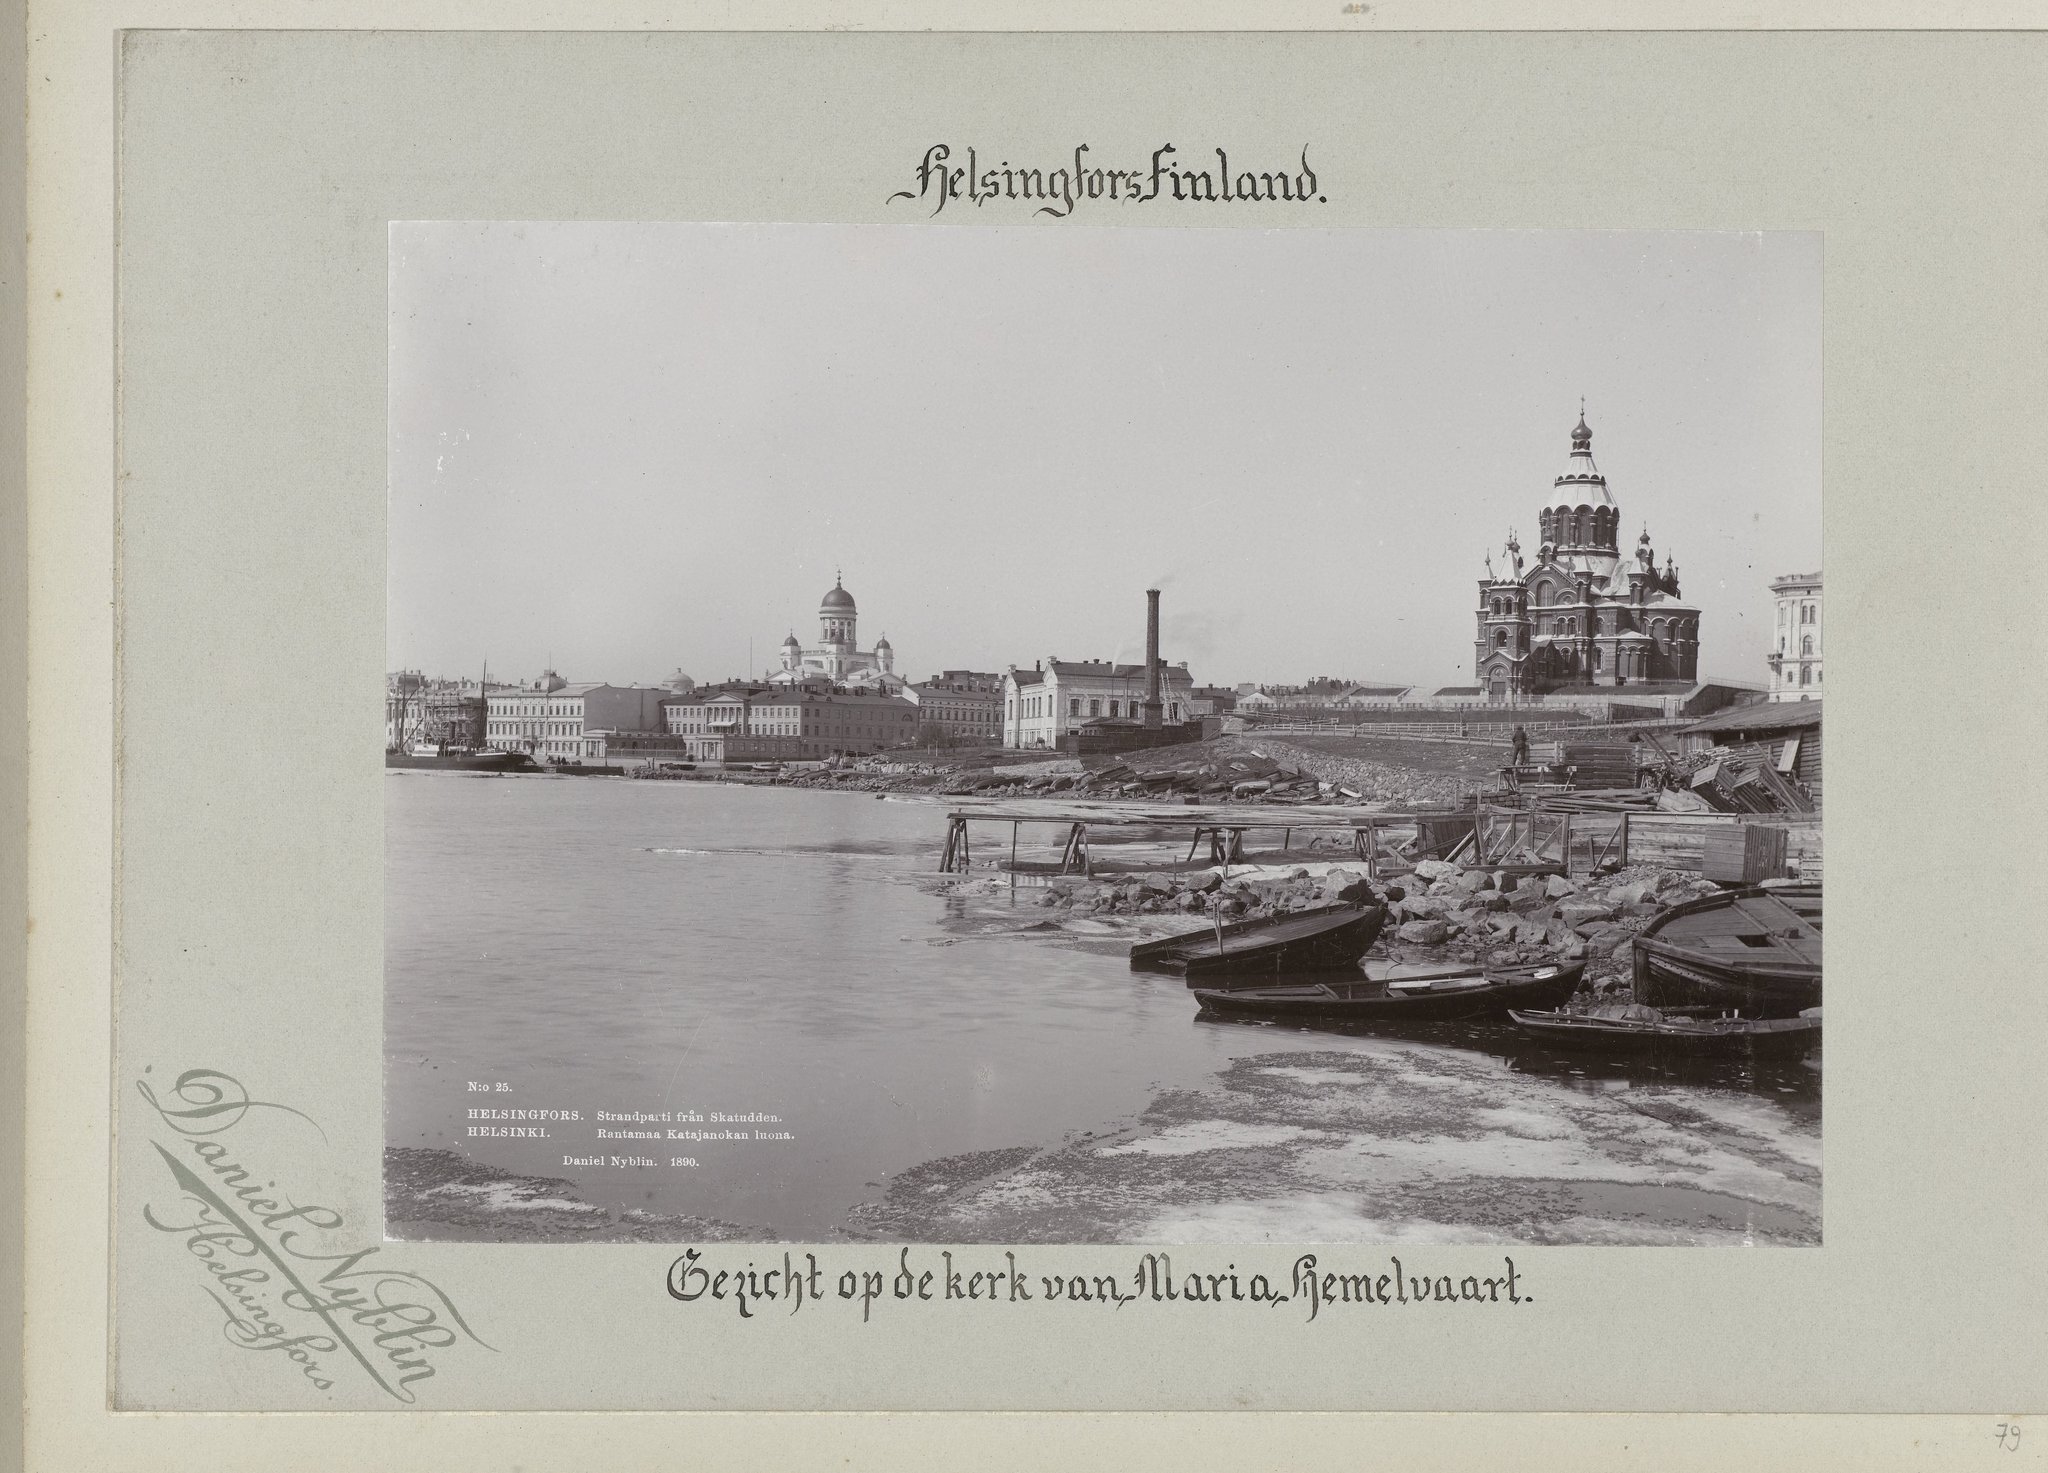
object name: photograph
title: No 25 Helsingfors Strandparti fran Skatudden, Daniel Nyblin 1890.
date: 1898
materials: paper, photographic support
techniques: albumen print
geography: helsinki